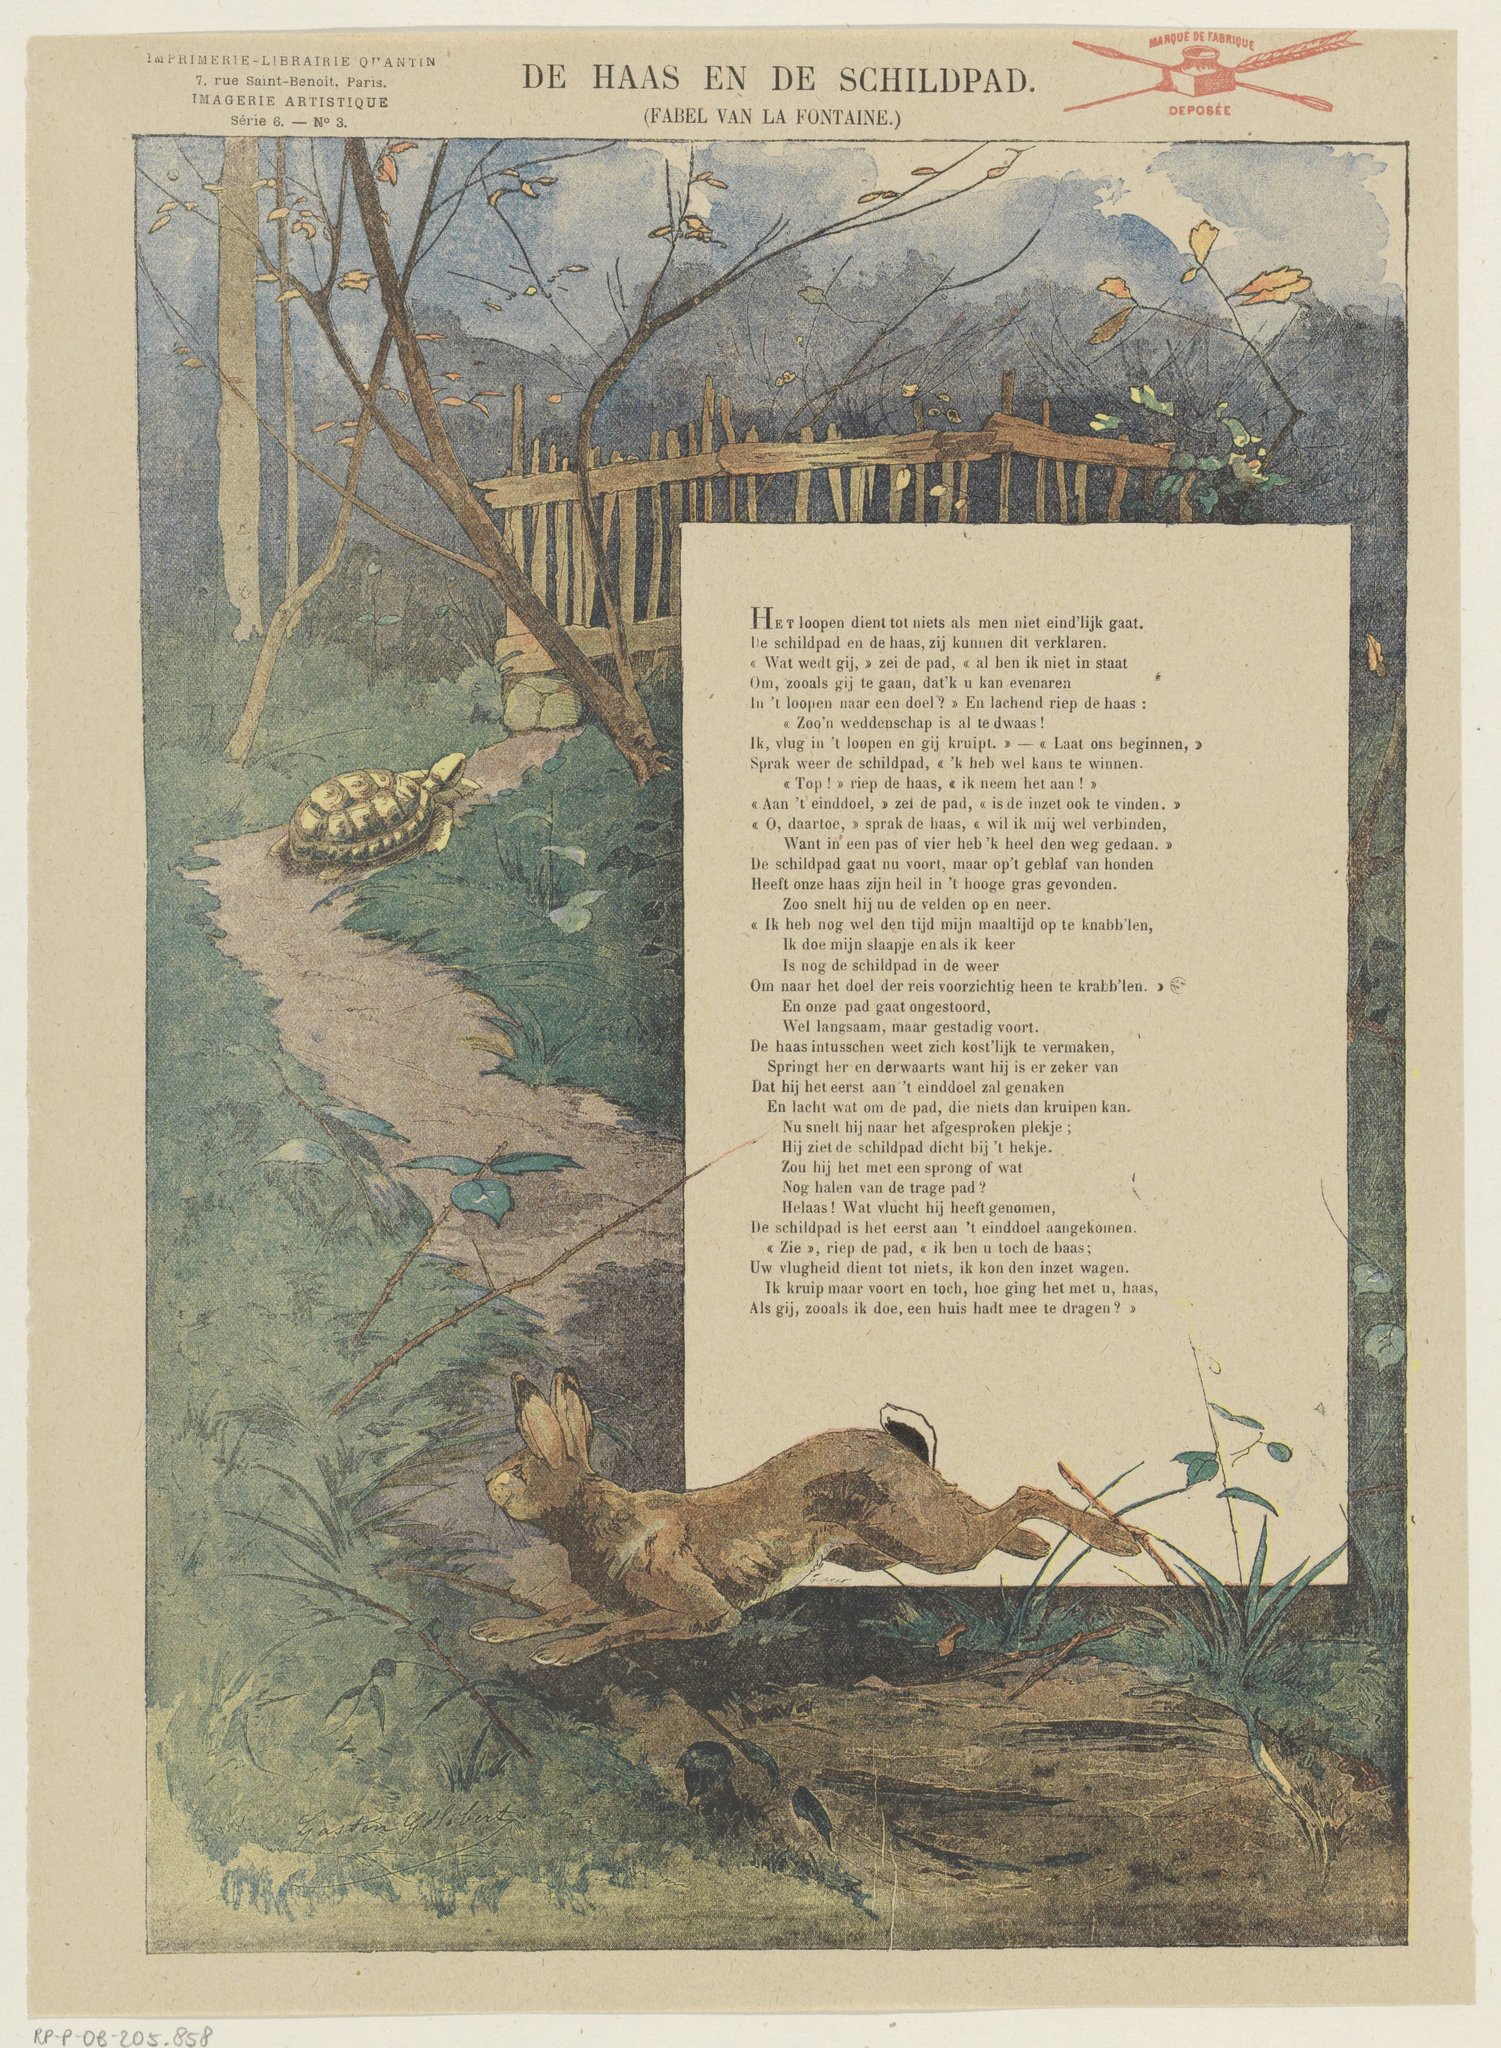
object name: popular print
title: De haas en de schildpad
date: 1876-1890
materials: paper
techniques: lithograph, letterpress printing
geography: paris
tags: tortoises, turtles, animals acting as human beings, rodents: hare, fables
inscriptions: : ‘marque de fabrique / deposée’, collector's mark: Lugt 2760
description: Blad met een grote voorstelling uit de fabel van Jean de La Fontaine, van de haas en de schildpad. Midden rechts een tekstblok met een vers. Genummerd linksboven: Série 6. - No. 3.